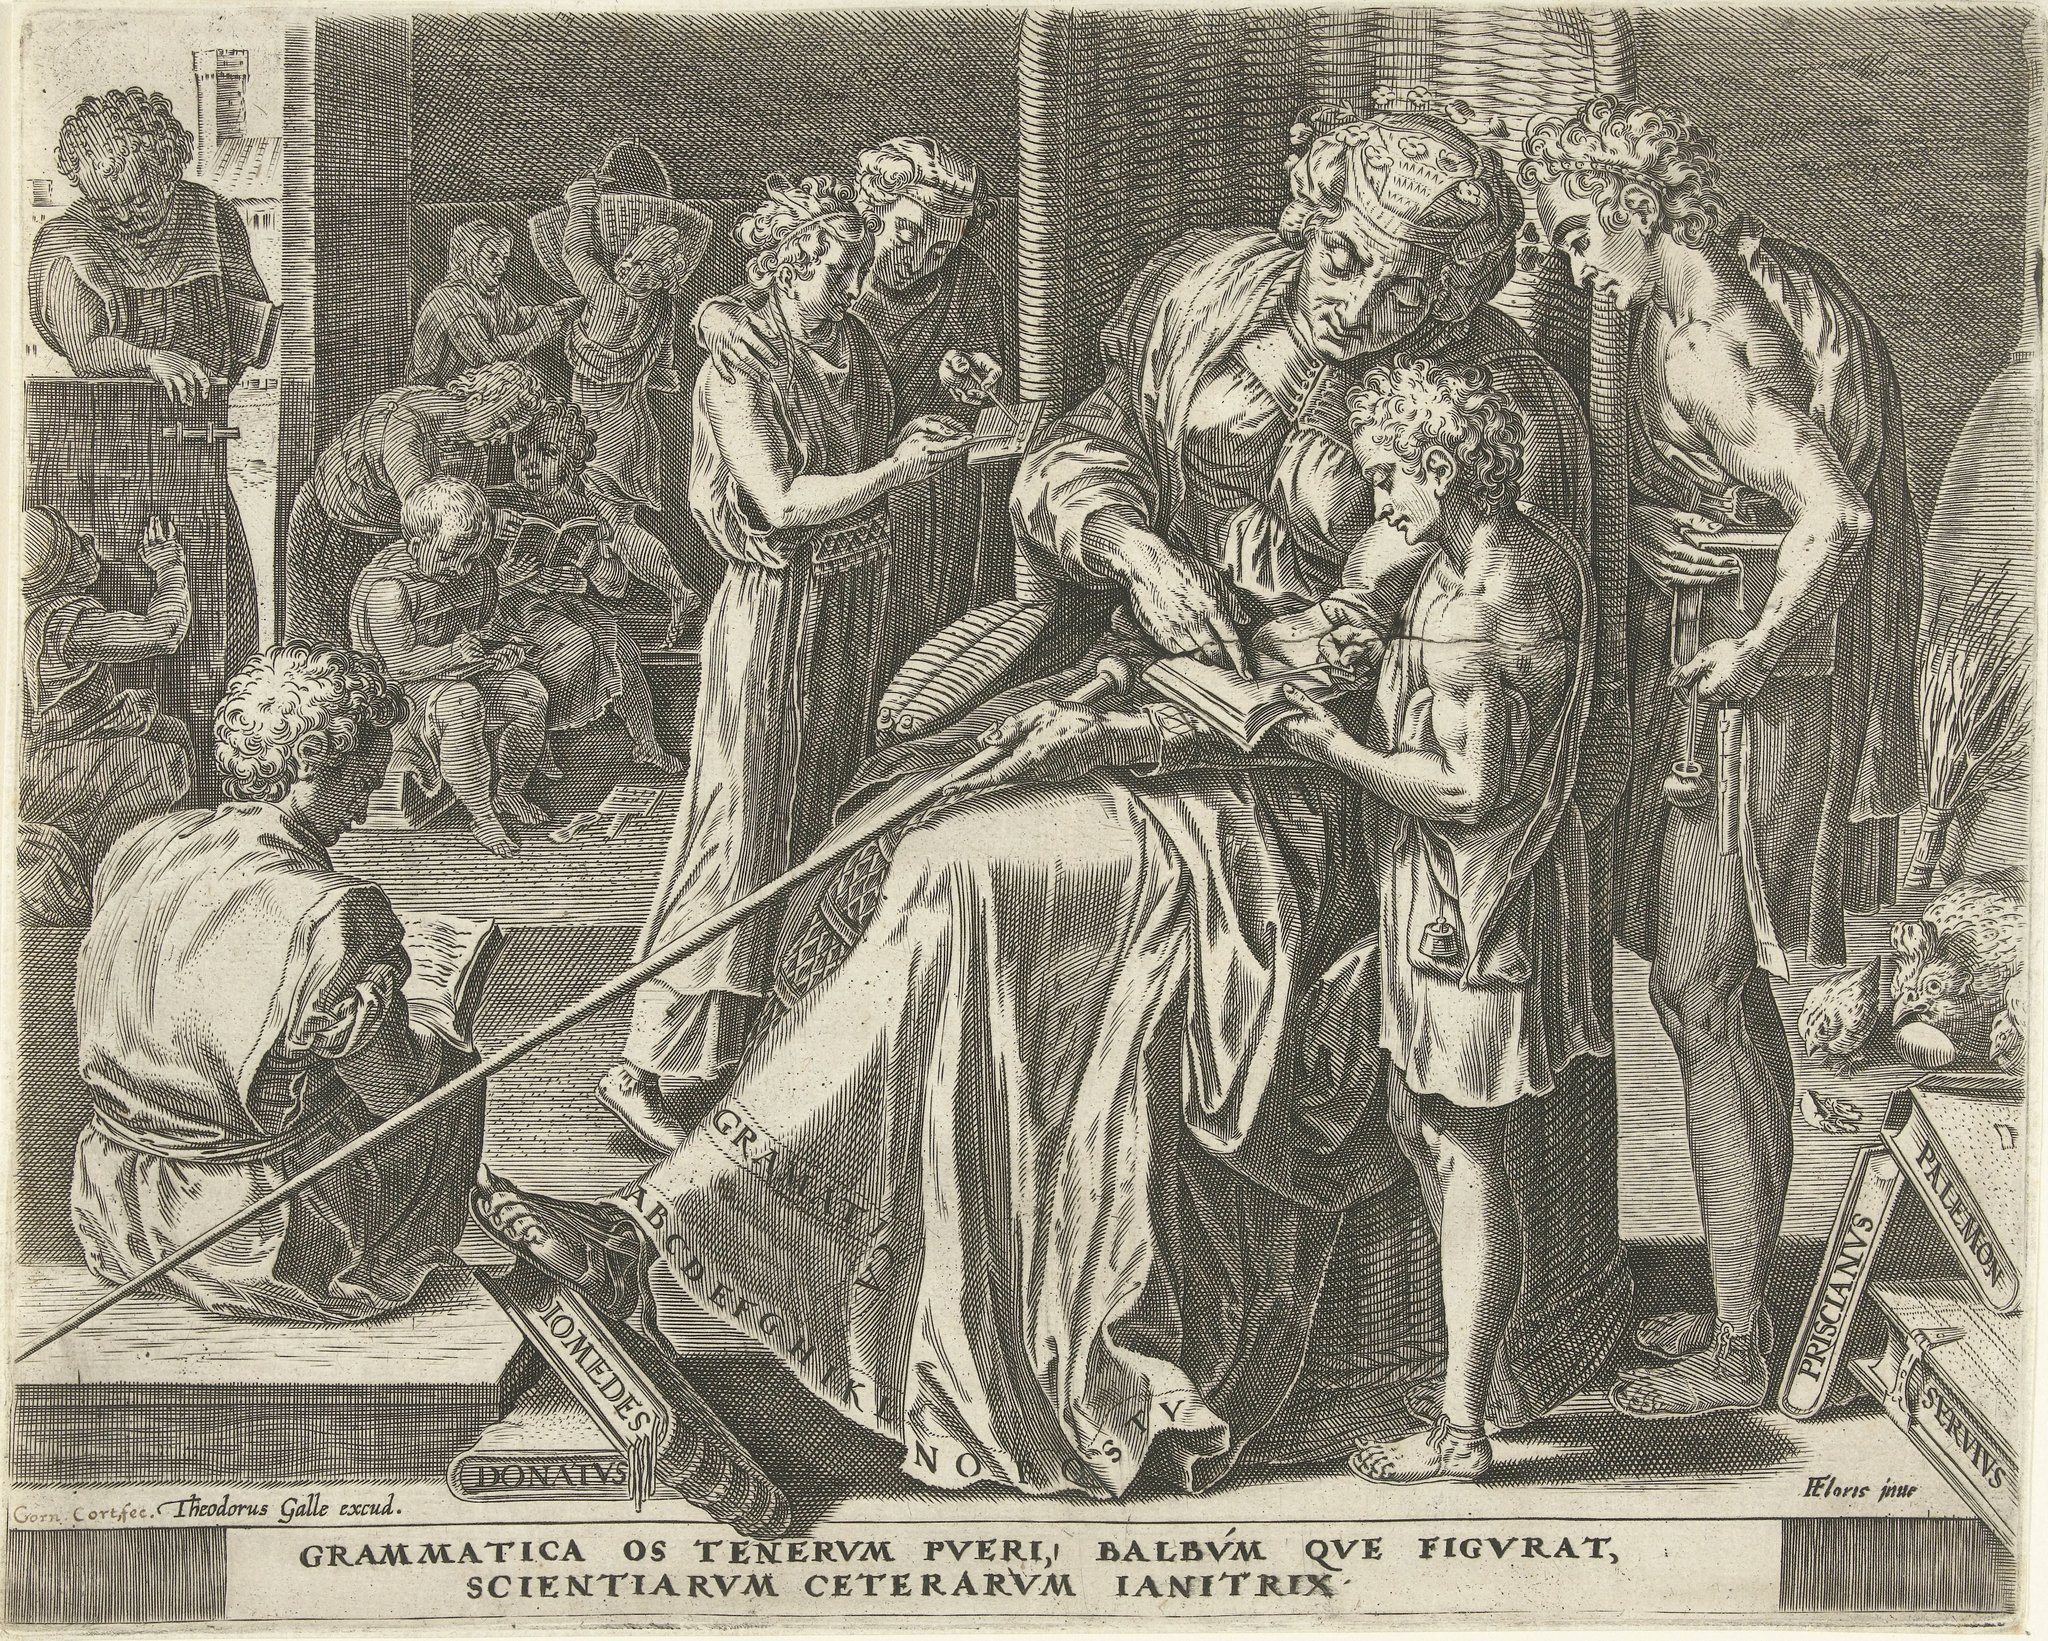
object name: print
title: De zeven vrije kunsten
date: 1565-1633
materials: paper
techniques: engraving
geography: antwerp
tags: 'grammatica' (~ trivium); 'grammatica' (ripa)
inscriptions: signature: ‘Corn. Cort fec.’, collector's mark: Lugt 2228, caption:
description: Grammatica zit als oudere lerares te midden van haar leerlingen. In de klas zitten leerlingen van verschillende leeftijden. Achter leren de jongste kinderen schrijven. Links voor leest een ouder kind in een boek. Grammatica helpt een andere leerling die met een boek naast haar staat. In haar schoot ligt een wijsstok. Op de grond liggen boeken van beroemde schrijvers op het gebied van de spraakkunst zoals Donatus en Diomedes.